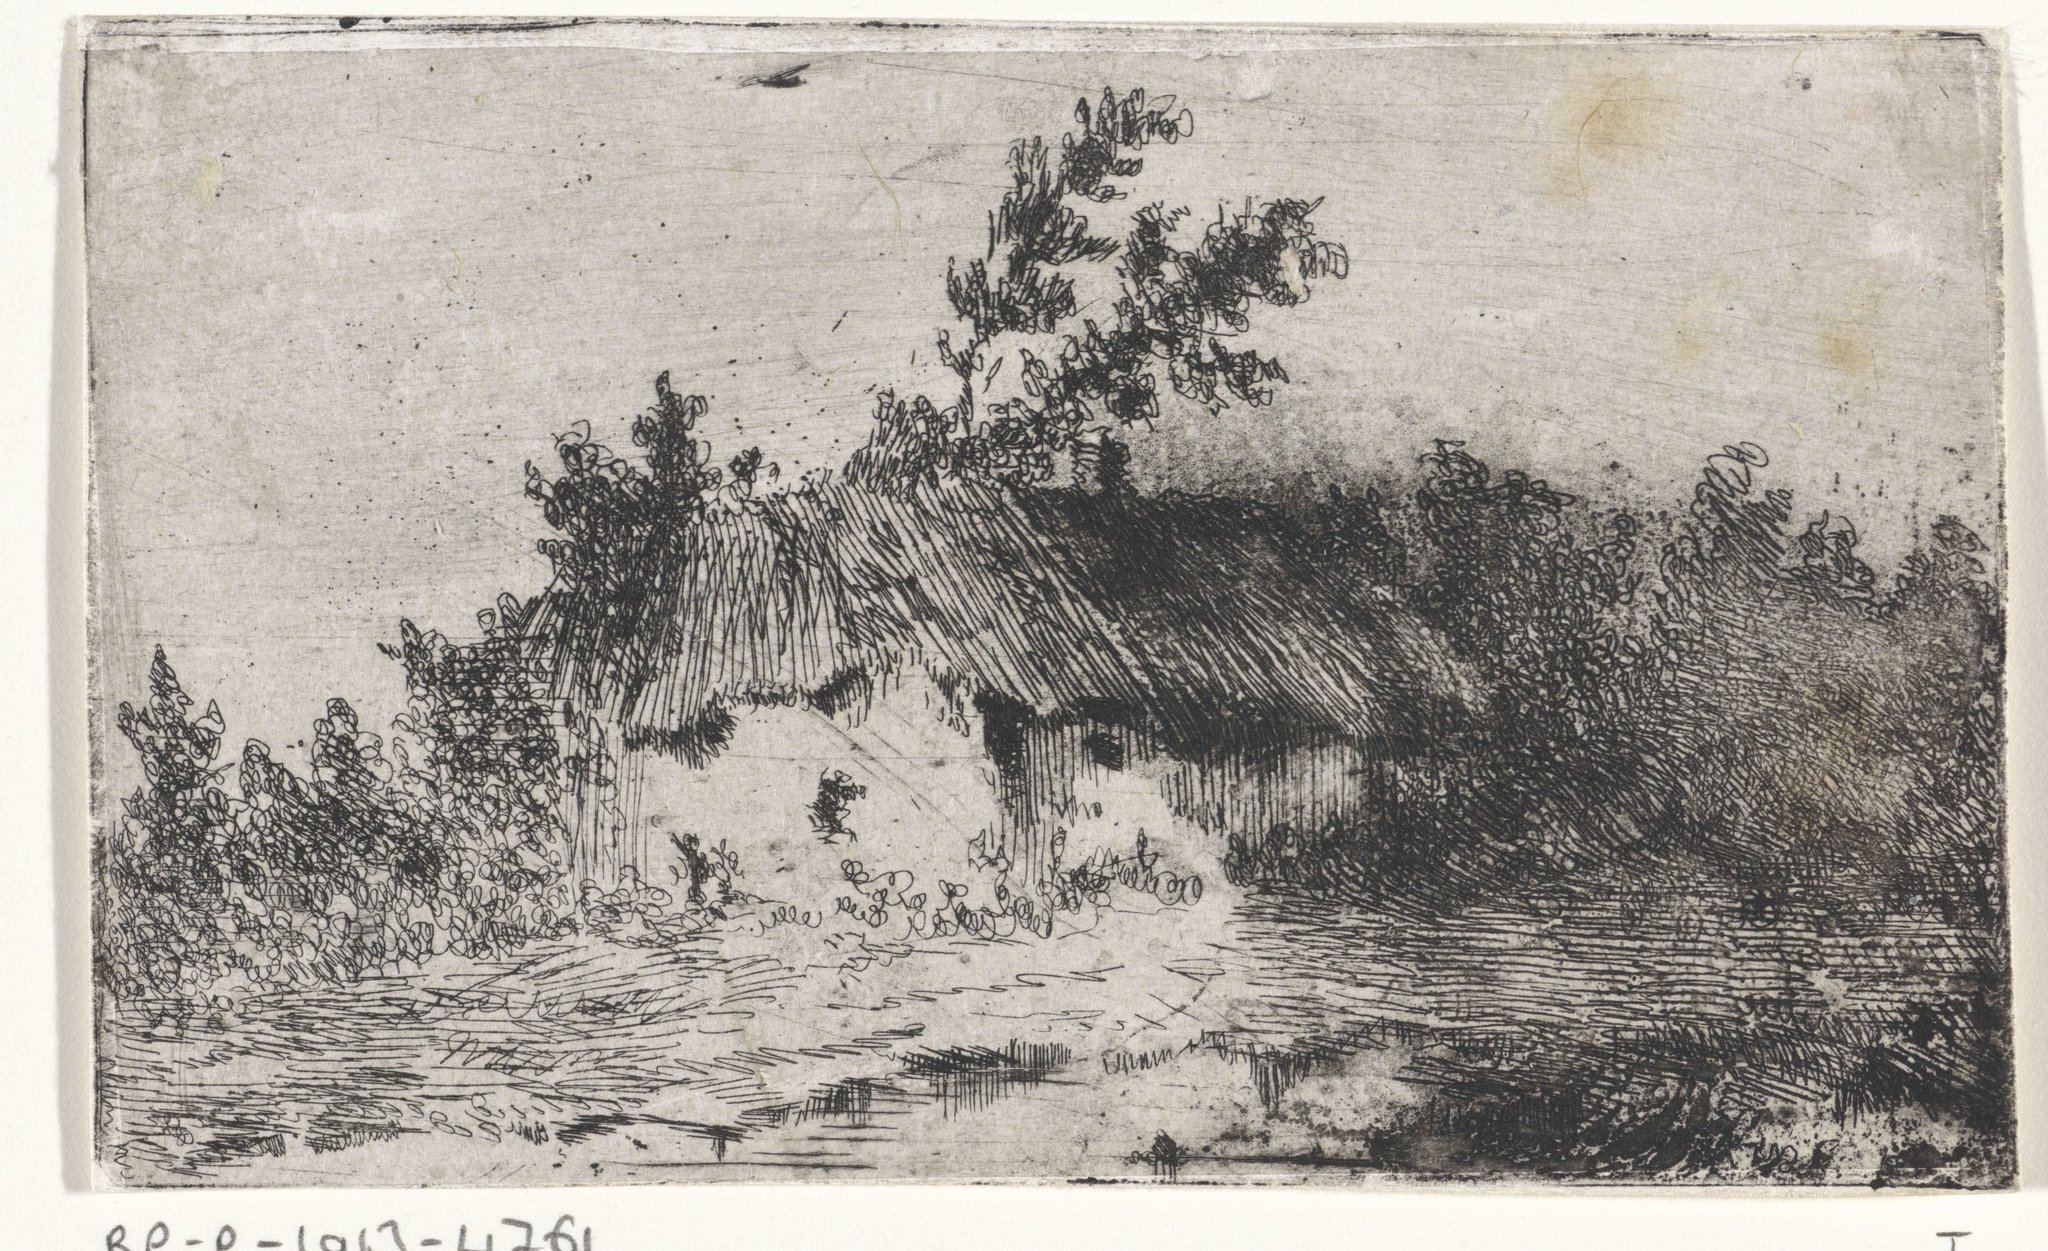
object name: print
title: Hut met rieten dak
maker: arnoud schaepkens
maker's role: print maker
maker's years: 1816-1904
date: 1831-1904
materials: paper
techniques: drypoint, etching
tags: cottage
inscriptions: collector's mark: Lugt 2228